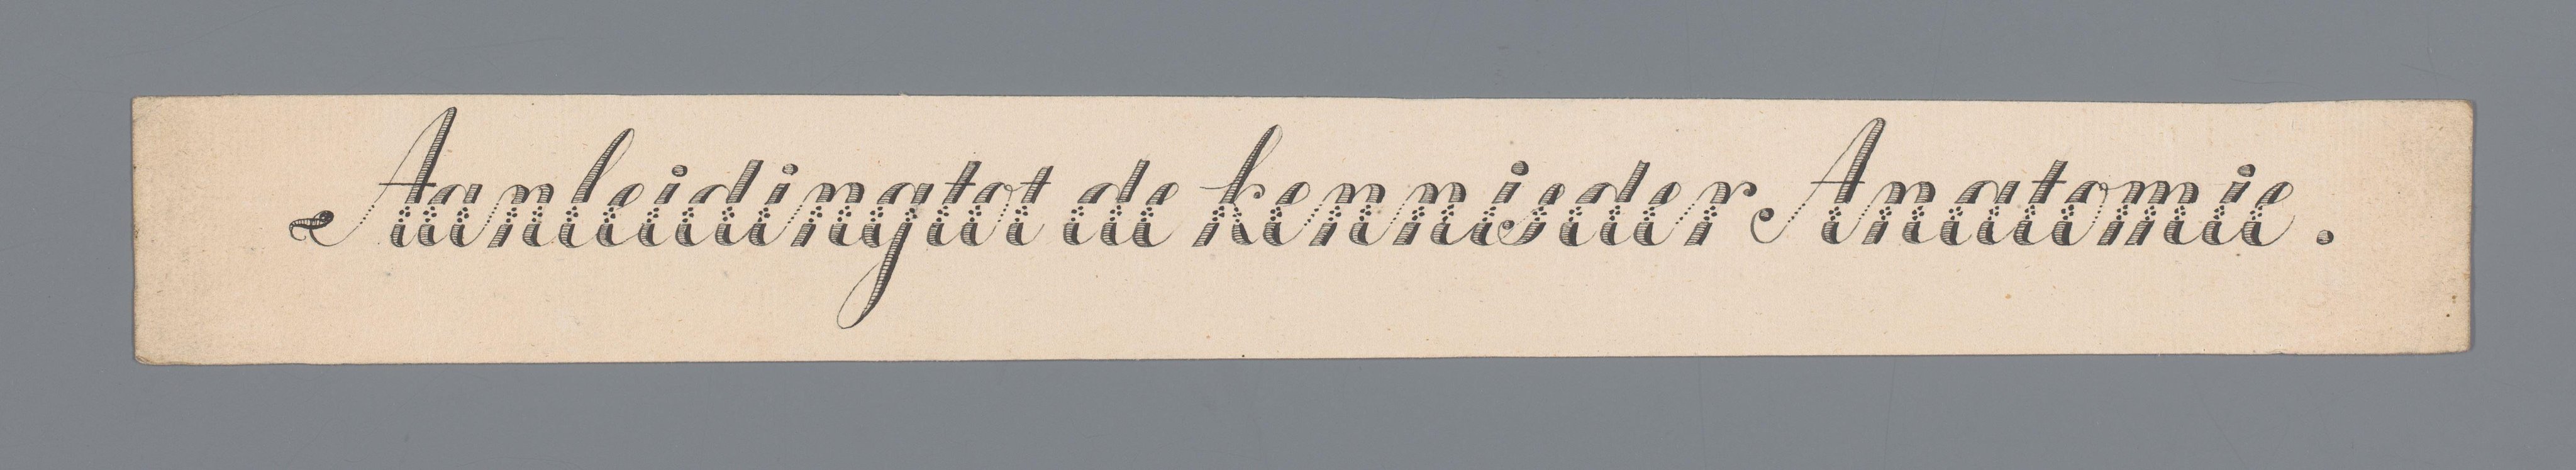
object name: print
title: Aanleiding tot de kennis der Anatomie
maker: Anonymous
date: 1828-1830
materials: paper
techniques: lithograph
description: Strook tekst. Onderdeel van een omslag met een serie van twaalf anatomische voorstellingen.